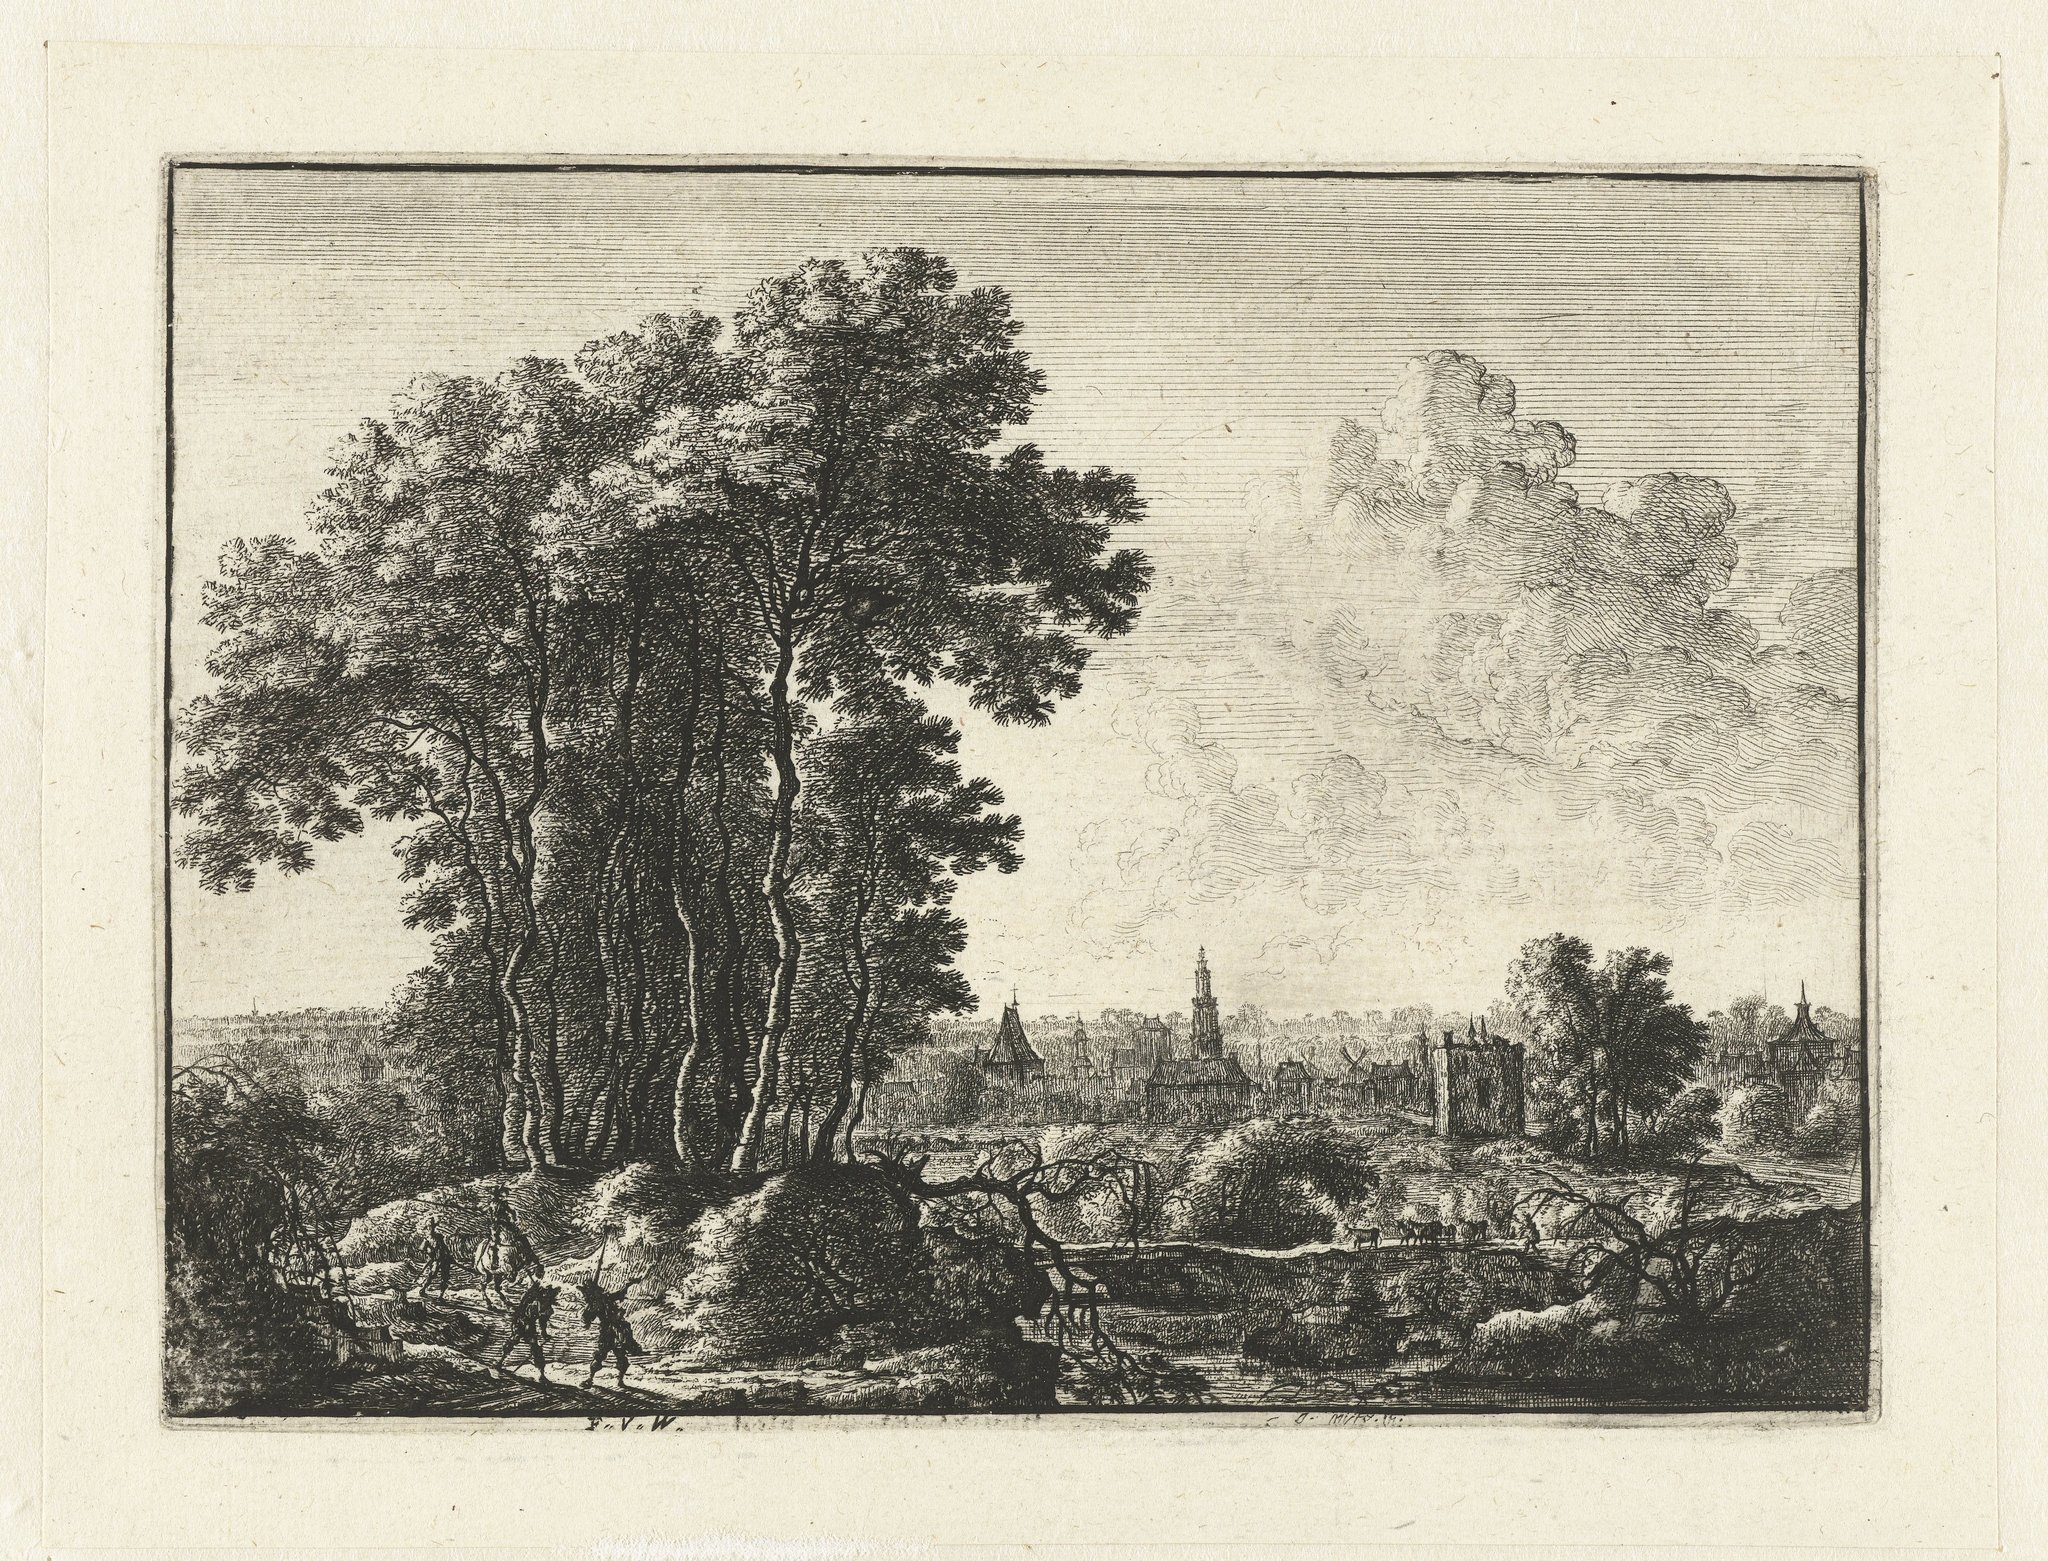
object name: print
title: Landschap met reizigers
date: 1643-1679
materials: paper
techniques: etching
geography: antwerp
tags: landscapes in the temperate zone, landscape with bridge, viaduct or aqueduct, village, windmill in landscape, 'en route', traveller under way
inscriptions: collector's mark: Lugt 2228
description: Een bosachtig landschap met een dorp aan een rivier. Op de voorgrond links drie reizigers te voet en één te paard.